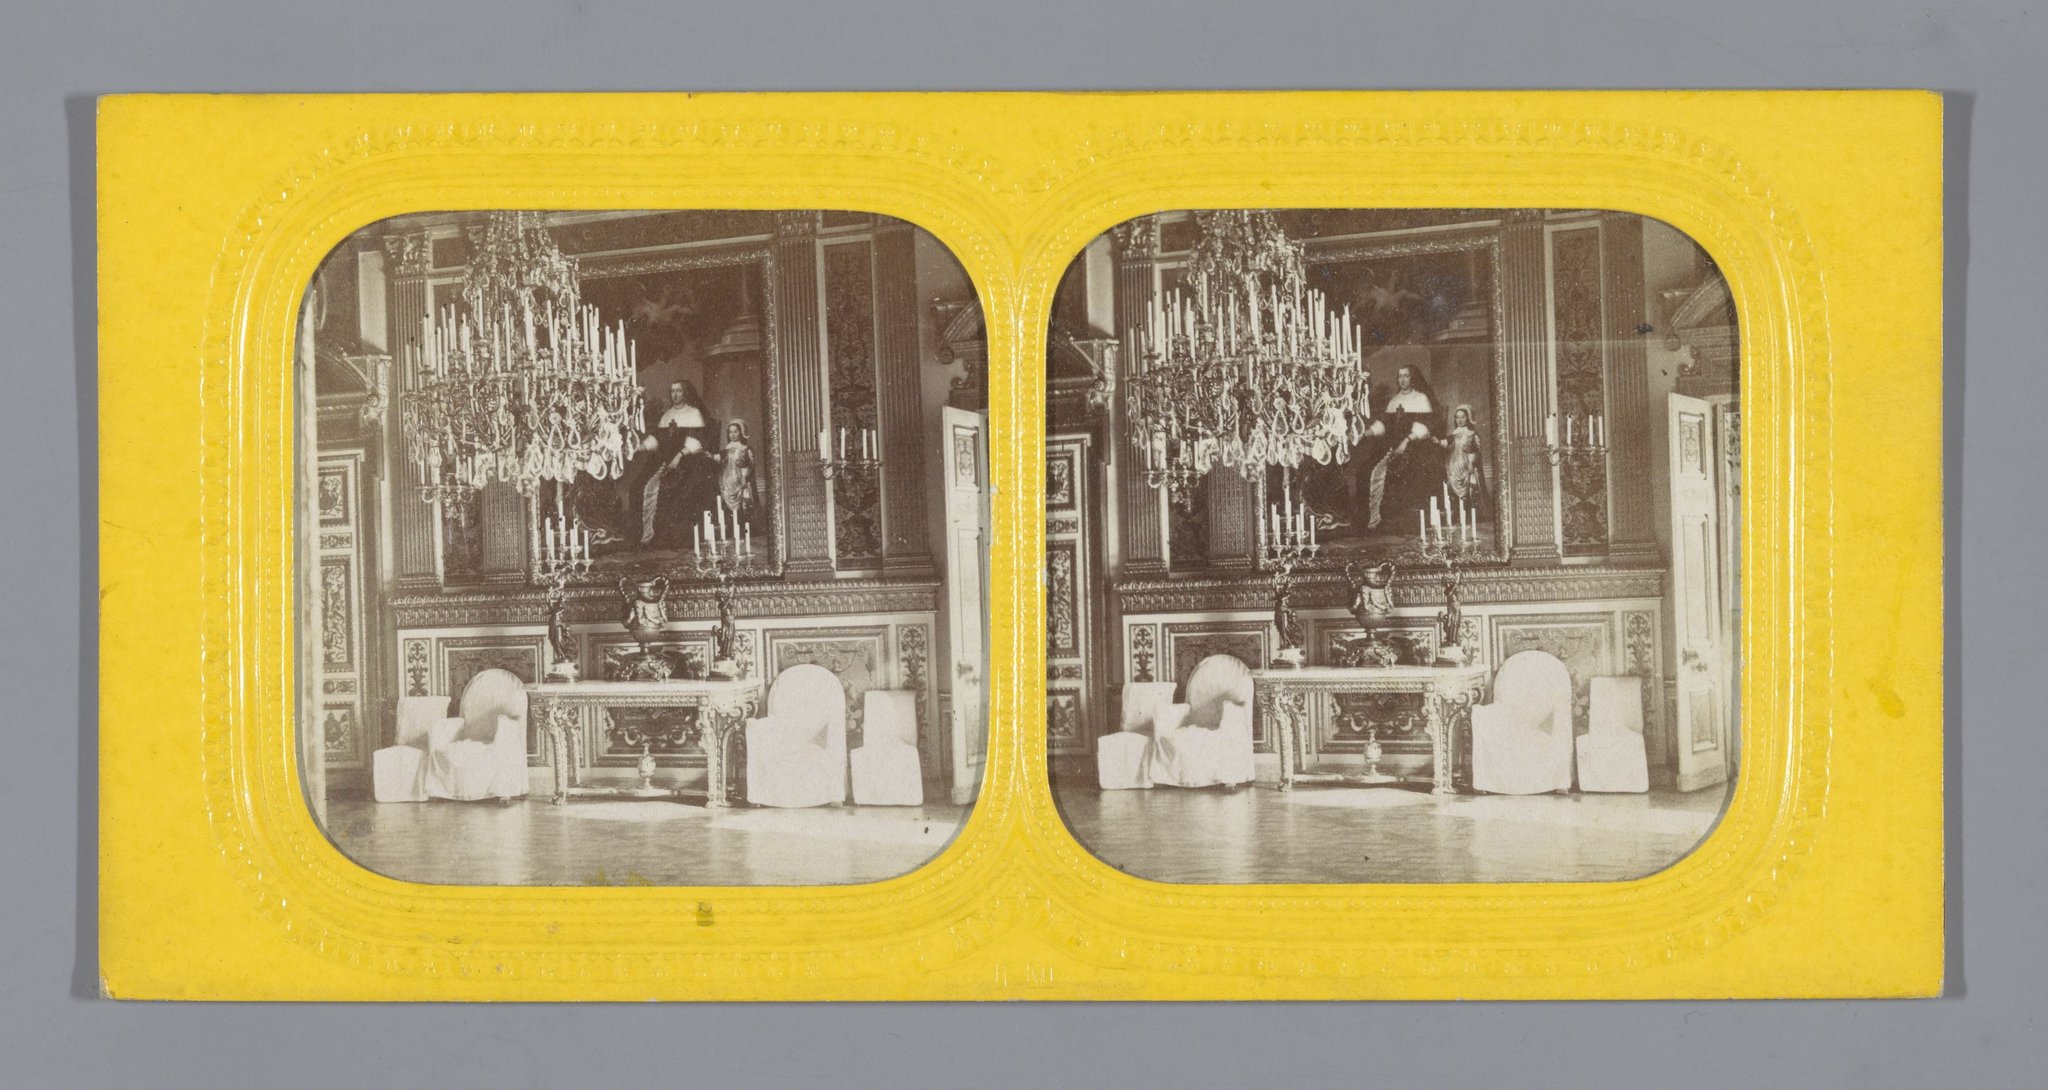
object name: tissue stereograph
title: Interieur van de Salon van Lodewijk XIV in het Palais des Tuileries, Parijs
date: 1864-1879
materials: cardboard, paper, photographic support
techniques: albumen print, hand coloring, perforating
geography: paris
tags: drawing-room, 'salon', chandelier, candelabrum, interior ~ representation of a building, tuileries palace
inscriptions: monogram: ‘J.M.’